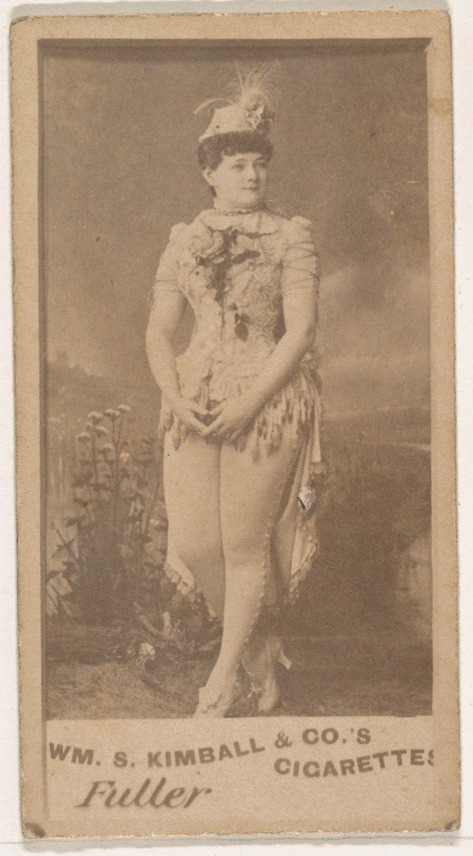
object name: photograph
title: Miss Fuller, from the Actresses series (N203) issued by Wm. S. Kimball & Co.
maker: william s. kimball & company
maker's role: publisher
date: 1889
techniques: color lithograph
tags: portraits,women,actresses